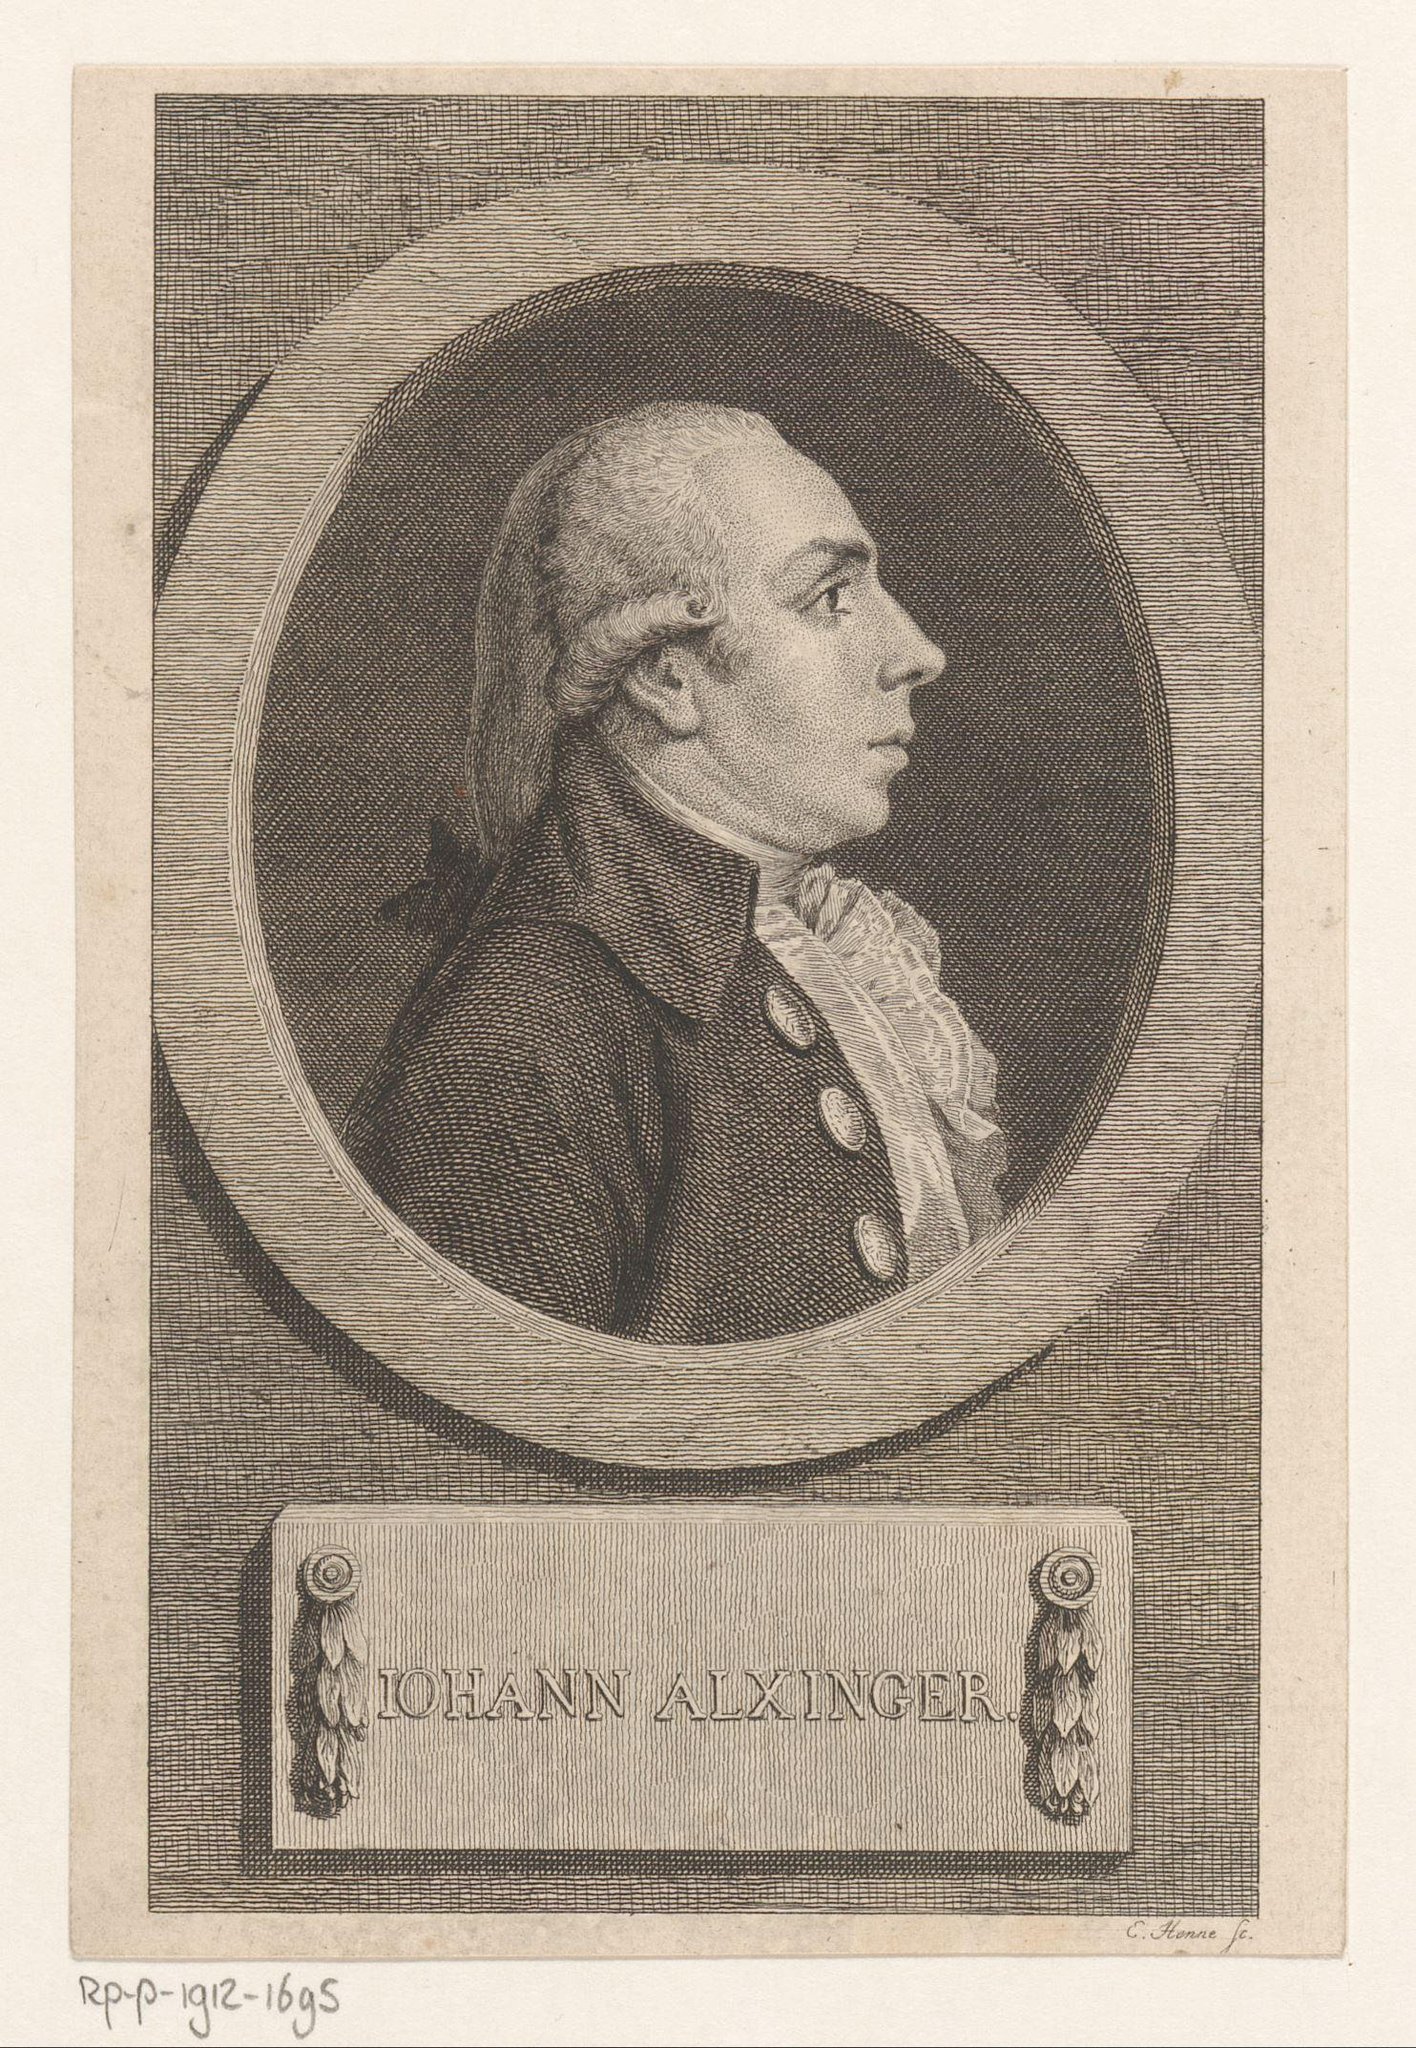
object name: print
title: Portret van Johann Baptist Edler von Alxinger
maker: eberhard siegfried henne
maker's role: print maker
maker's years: 1759-1828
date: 1769-1828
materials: paper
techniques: engraving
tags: vienna, historical persons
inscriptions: collector's mark: Lugt 2228